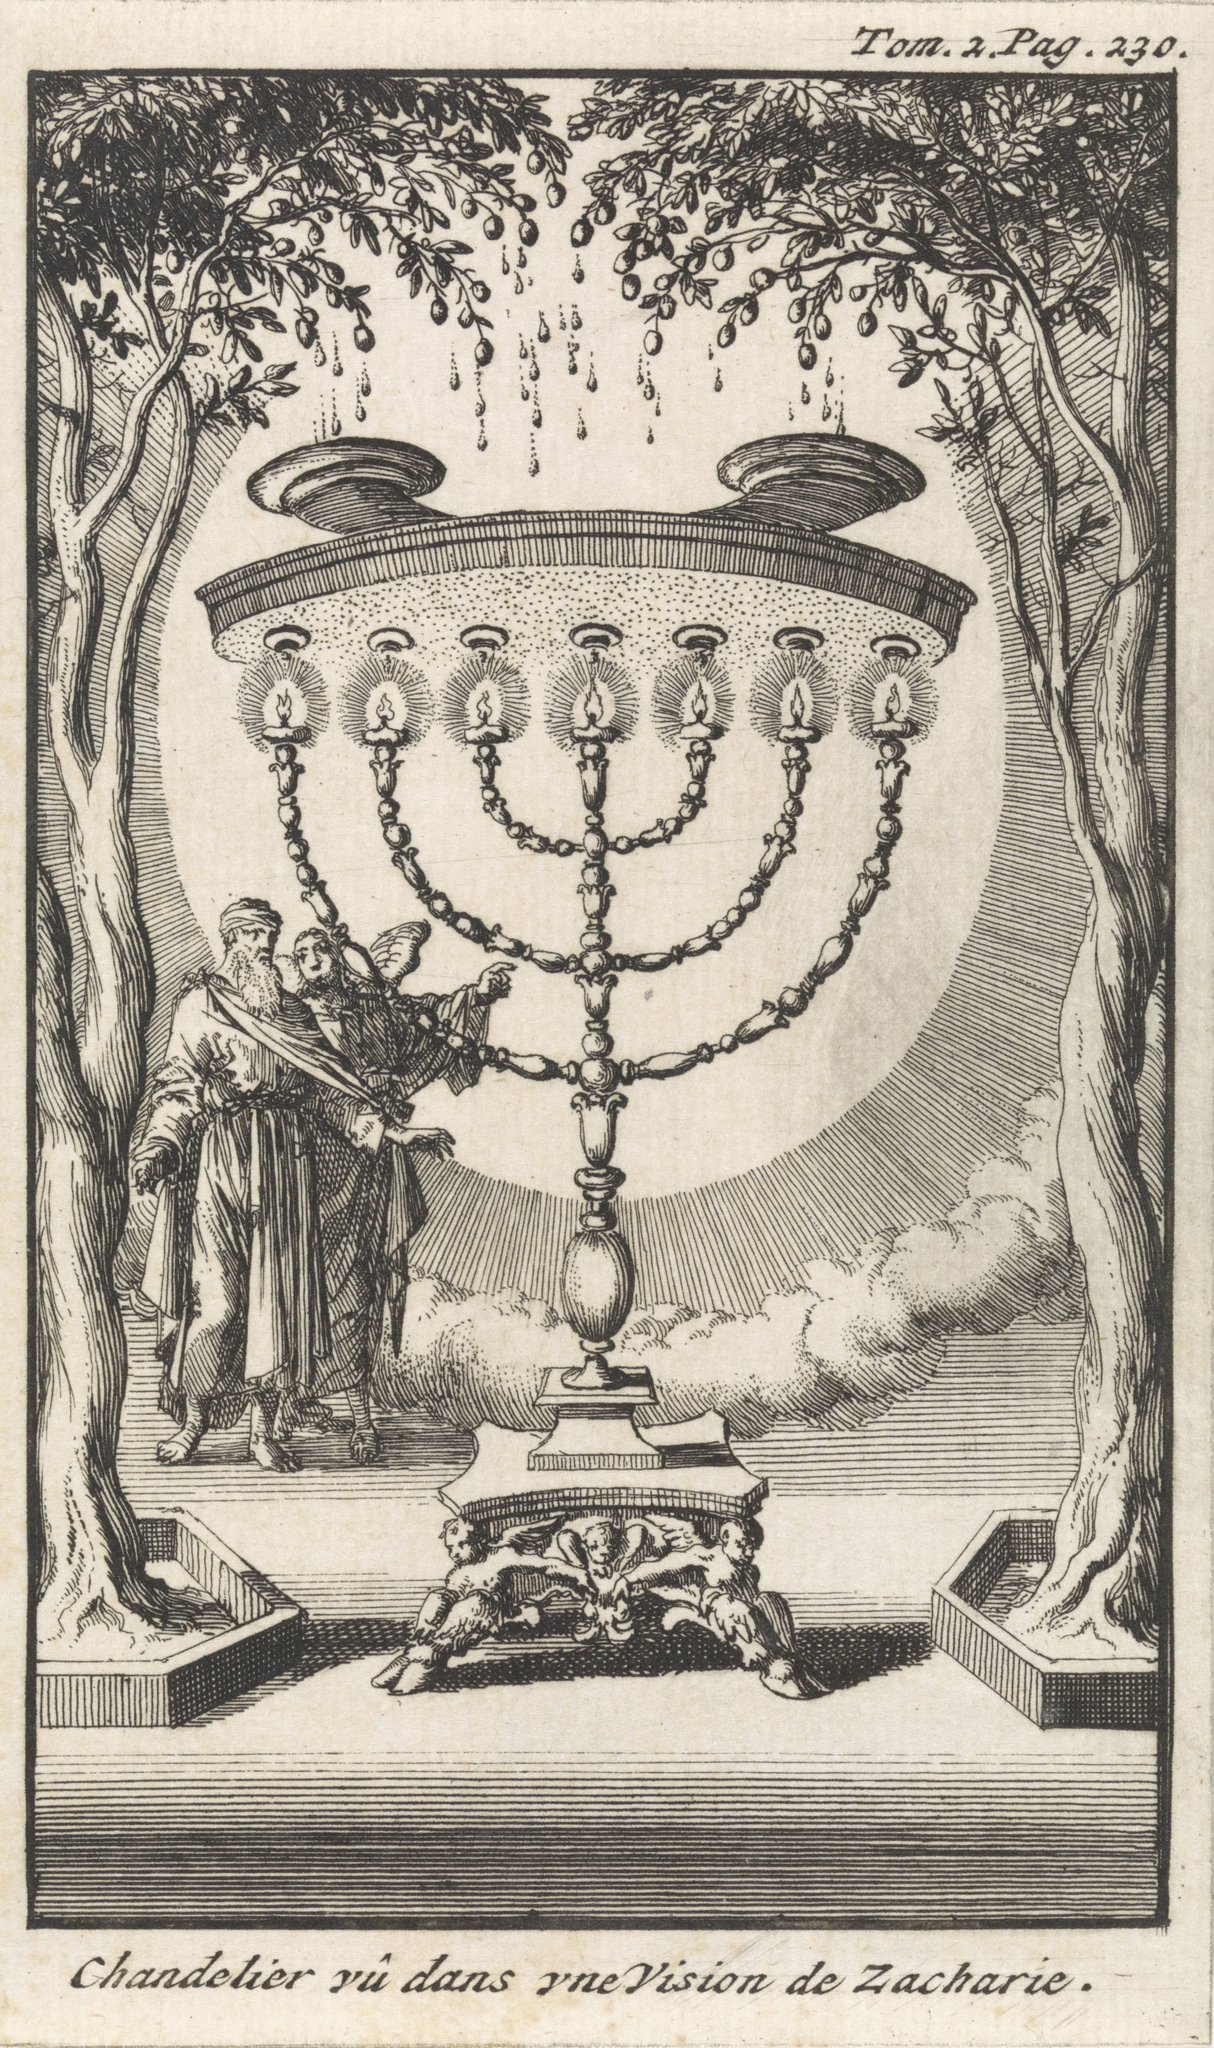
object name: print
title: Zacharias aanschouwt de menora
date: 1705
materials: paper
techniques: etching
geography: amsterdam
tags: seven lamps ~ 'menorah'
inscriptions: collector's mark: Lugt 2228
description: Illustratie uit: Cunaeus, Petrus. La republique des Hebreux, 3 delen. Amsterdam: Pieter Mortier, 1705, dl. II, p. 230.